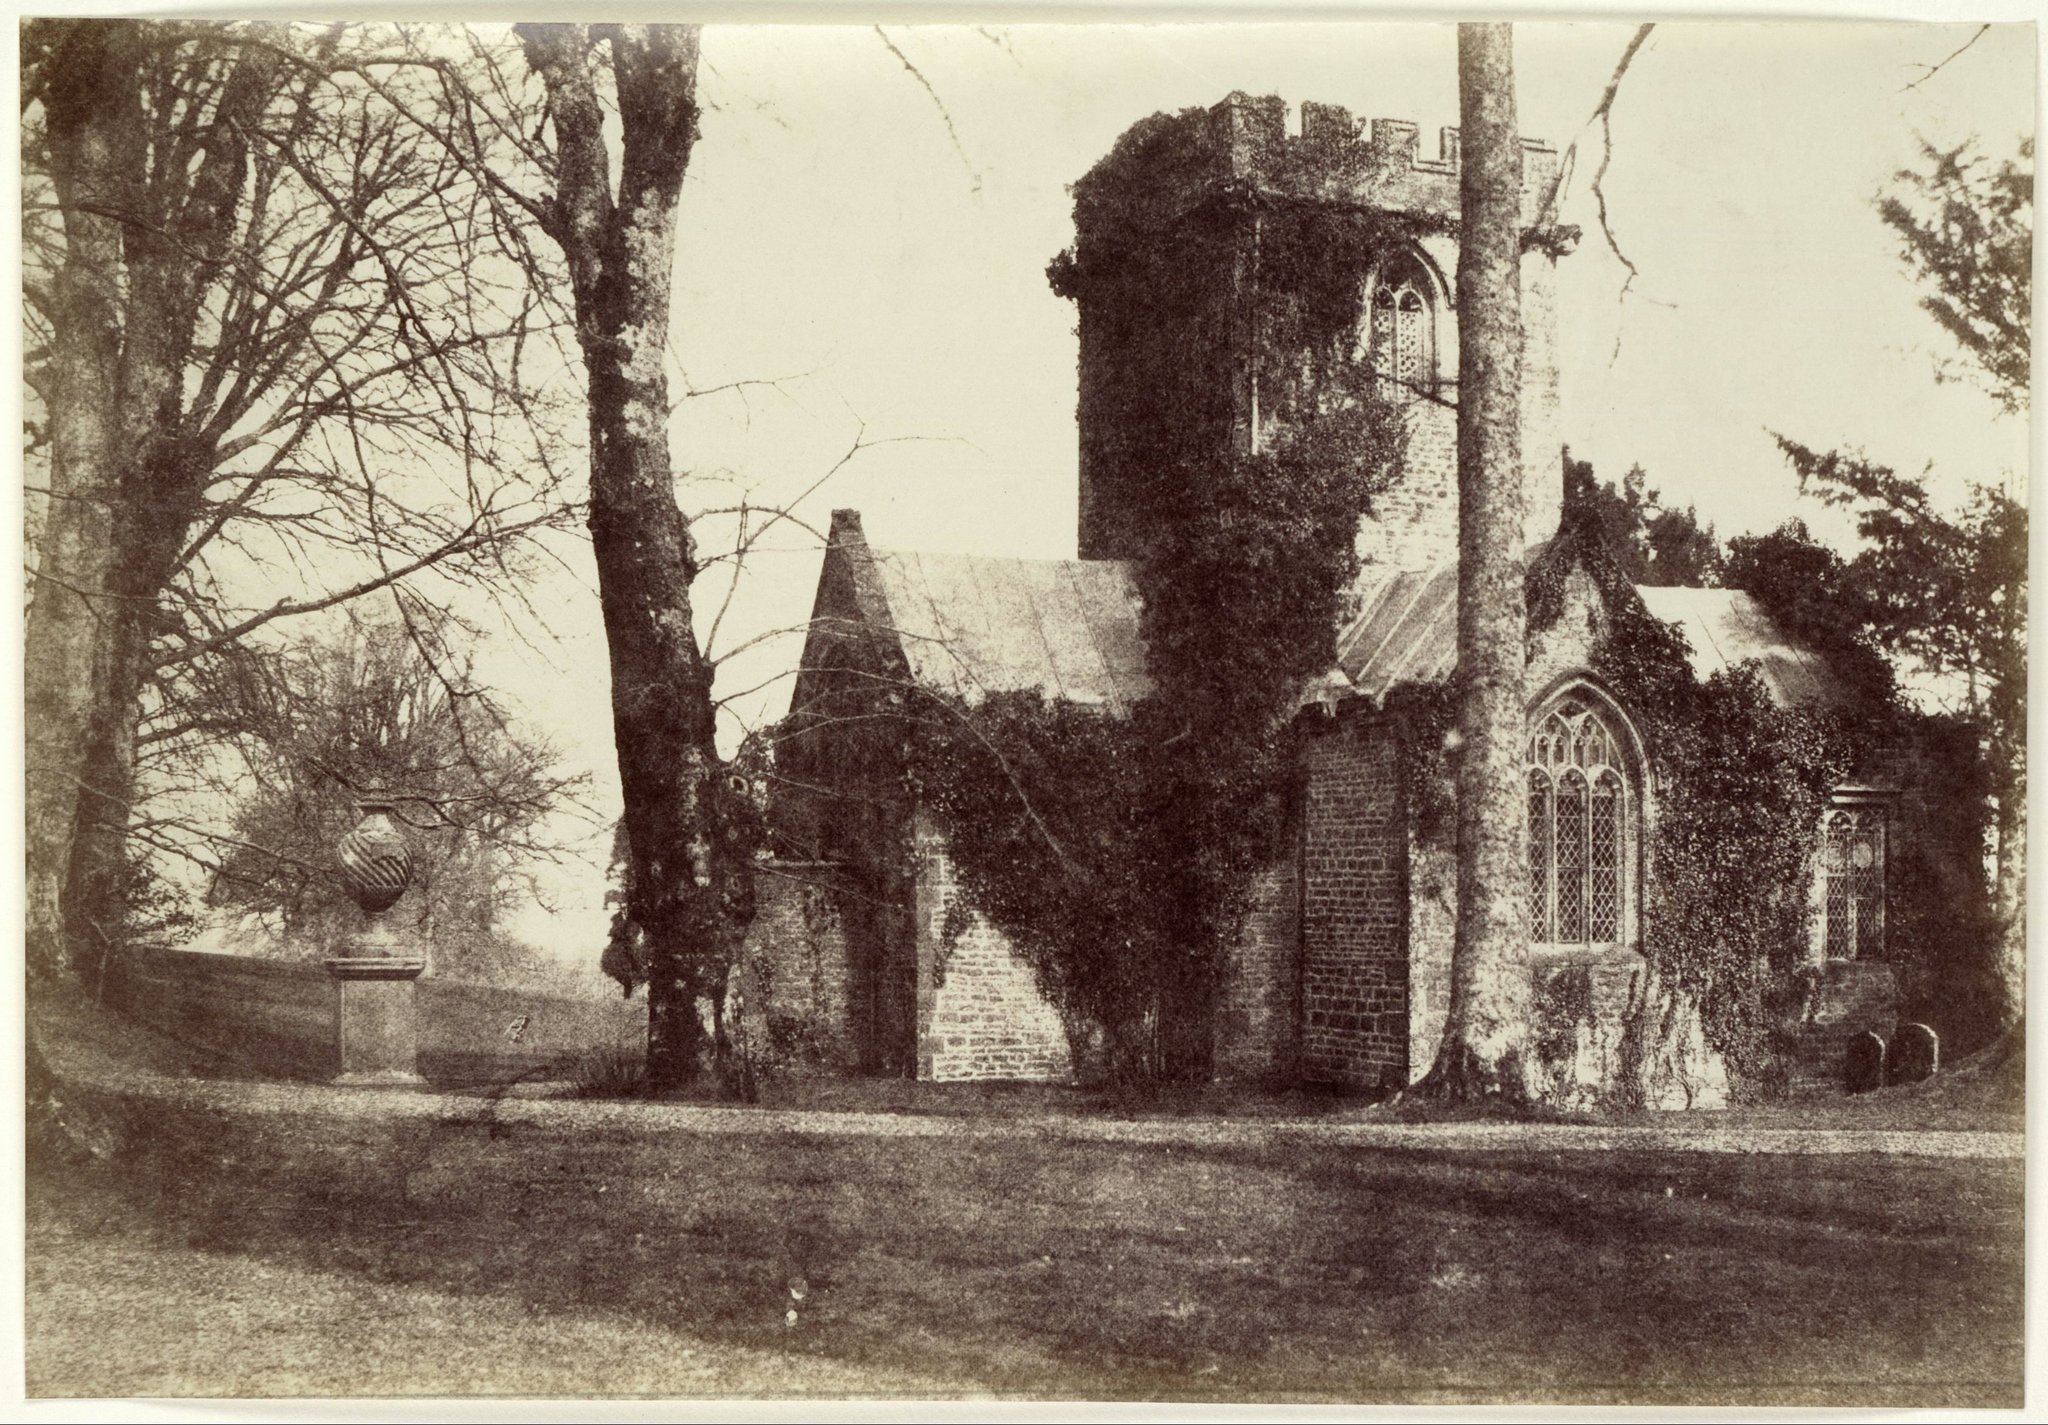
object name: photograph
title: Parochiekerk in Melbury Bubb, Dorset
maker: Anonymous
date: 1850-1855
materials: photographic support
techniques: salted paper print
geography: melbury bubb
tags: church (exterior)